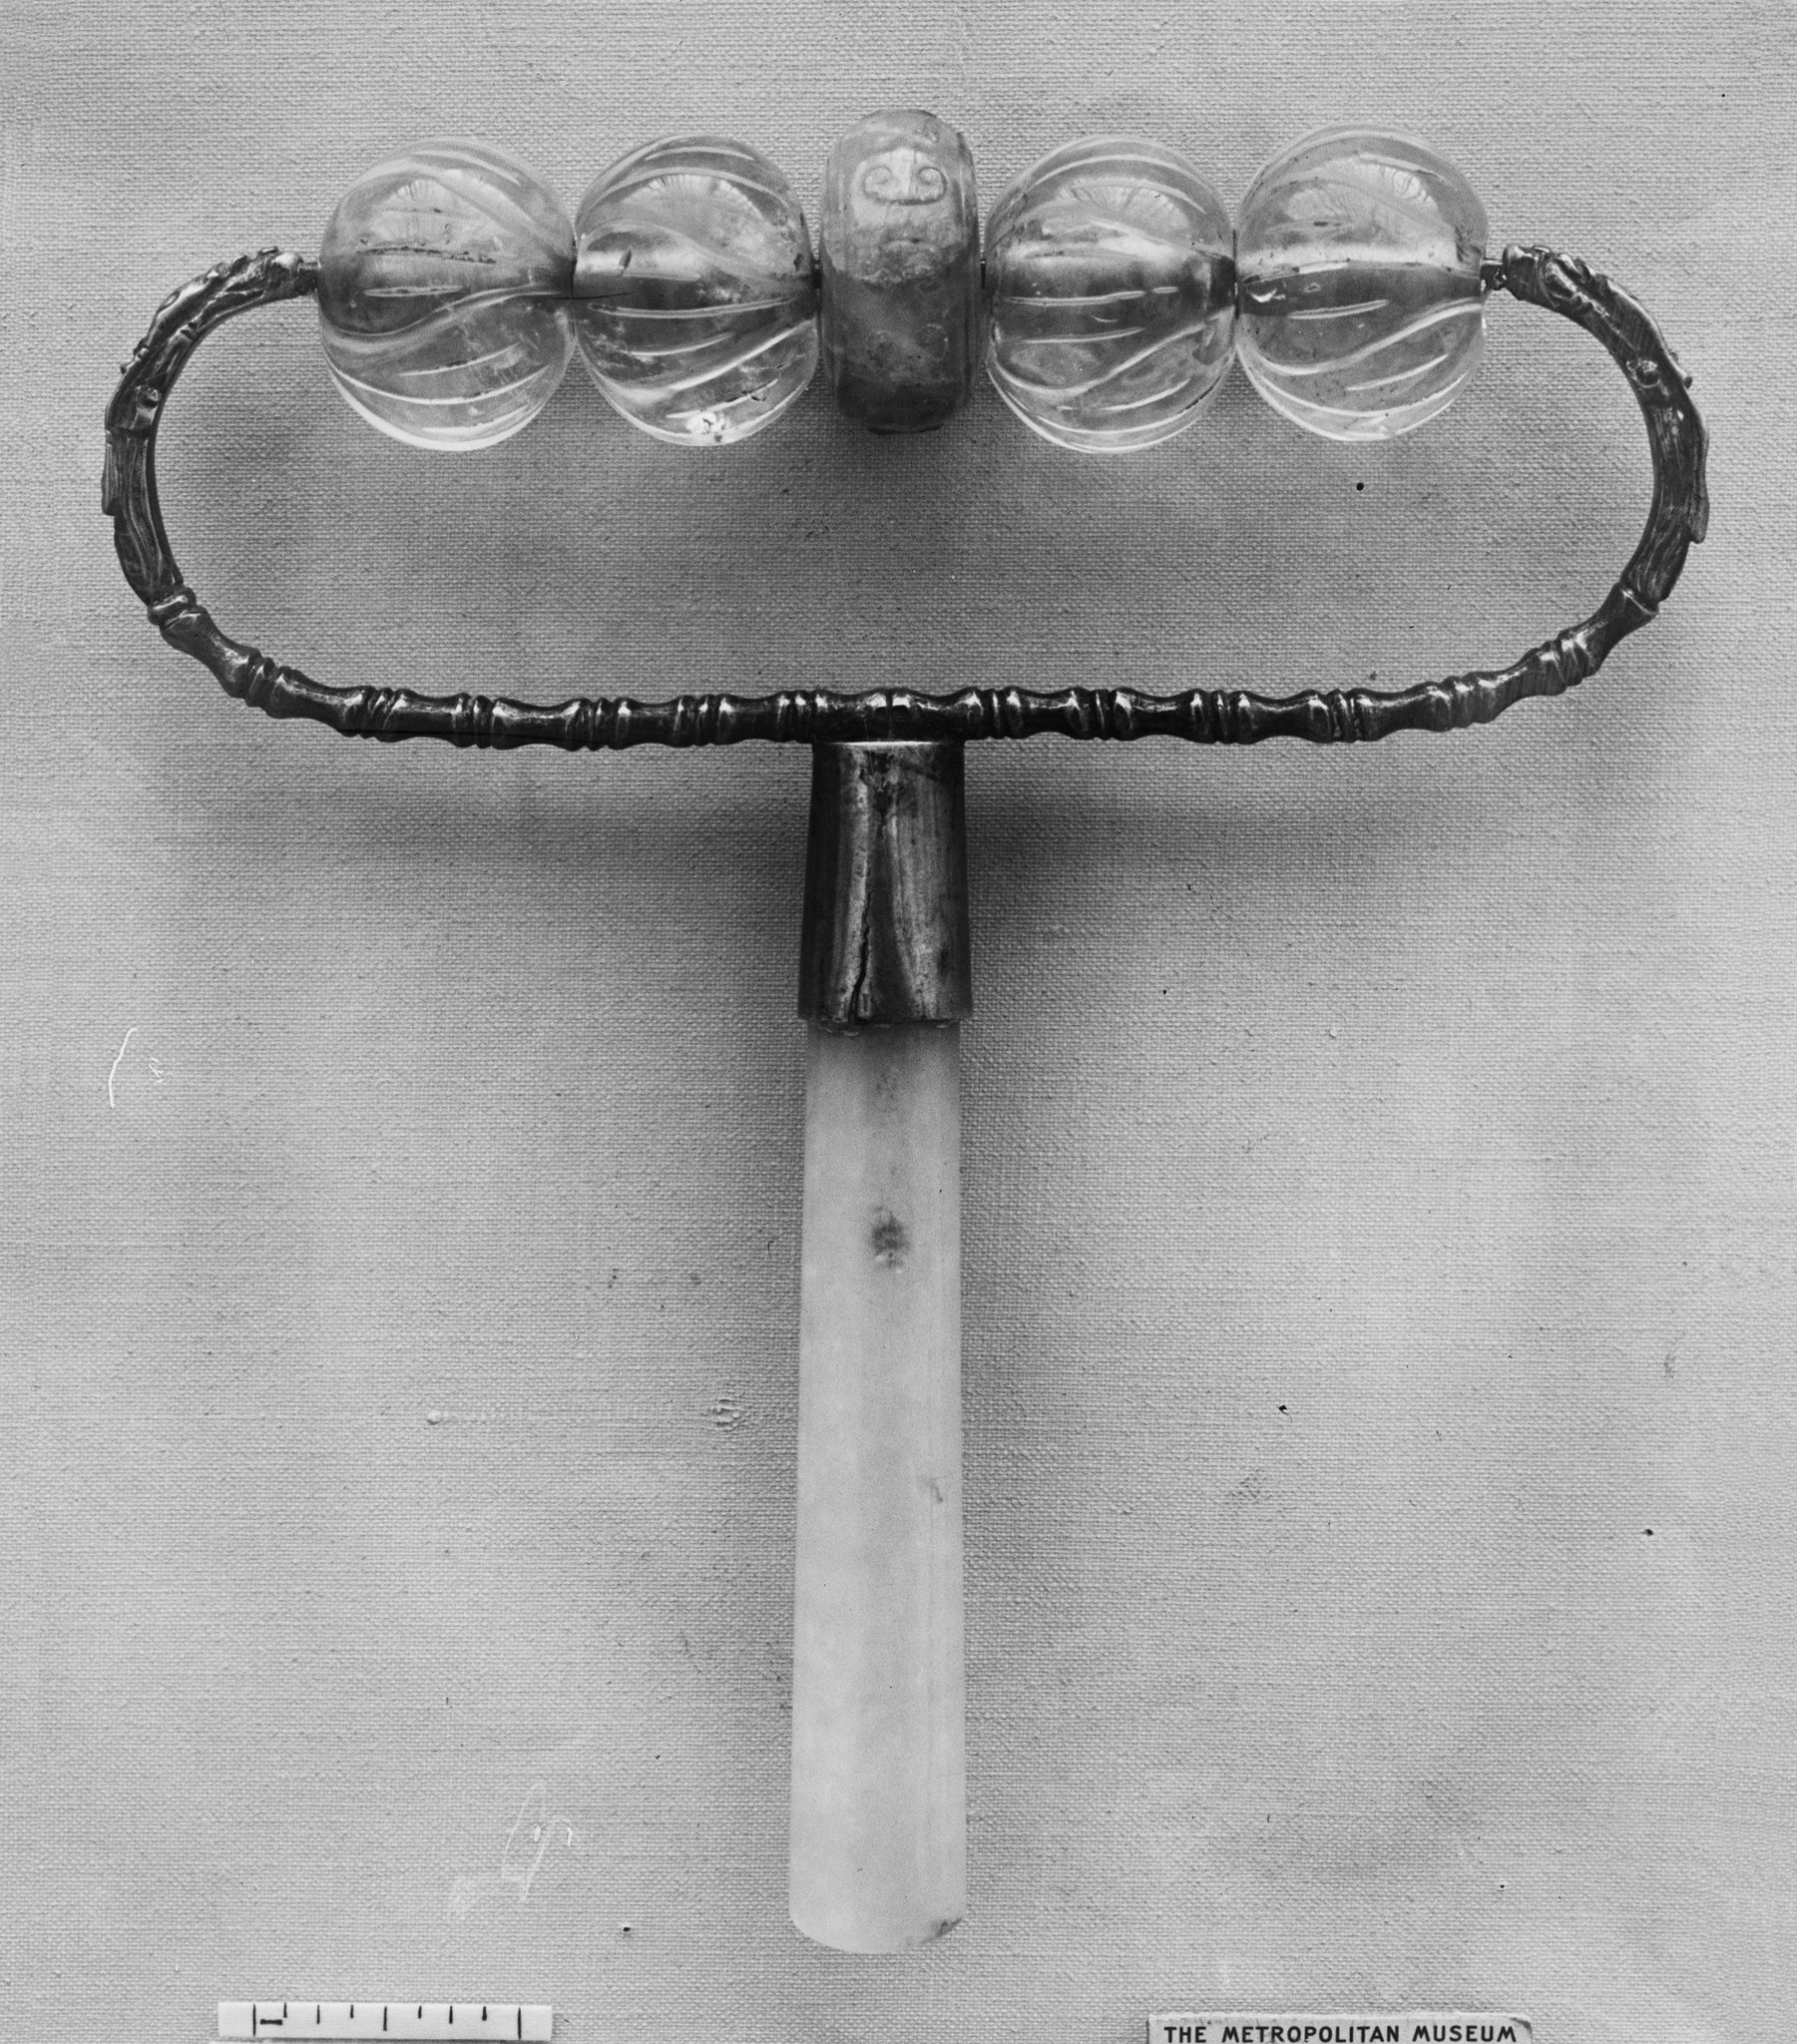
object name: massage roll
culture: chinese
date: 1736-1795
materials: gemstone, bronze, crystal, jade